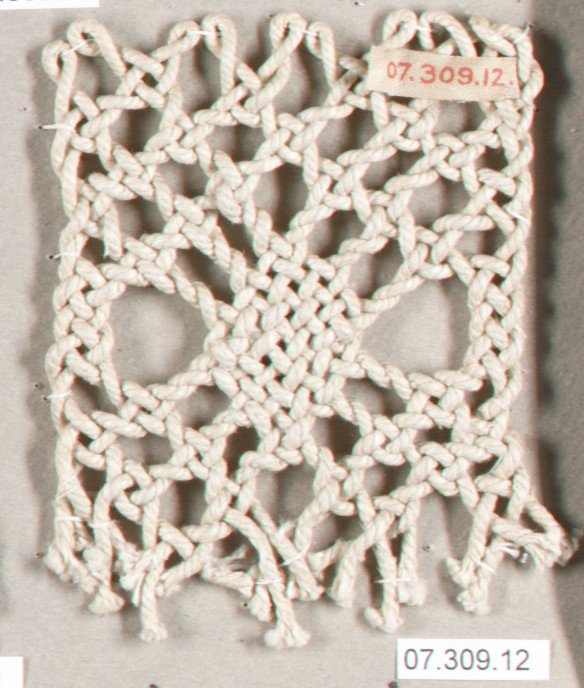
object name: stitch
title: Example of lace stitch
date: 1801-2000